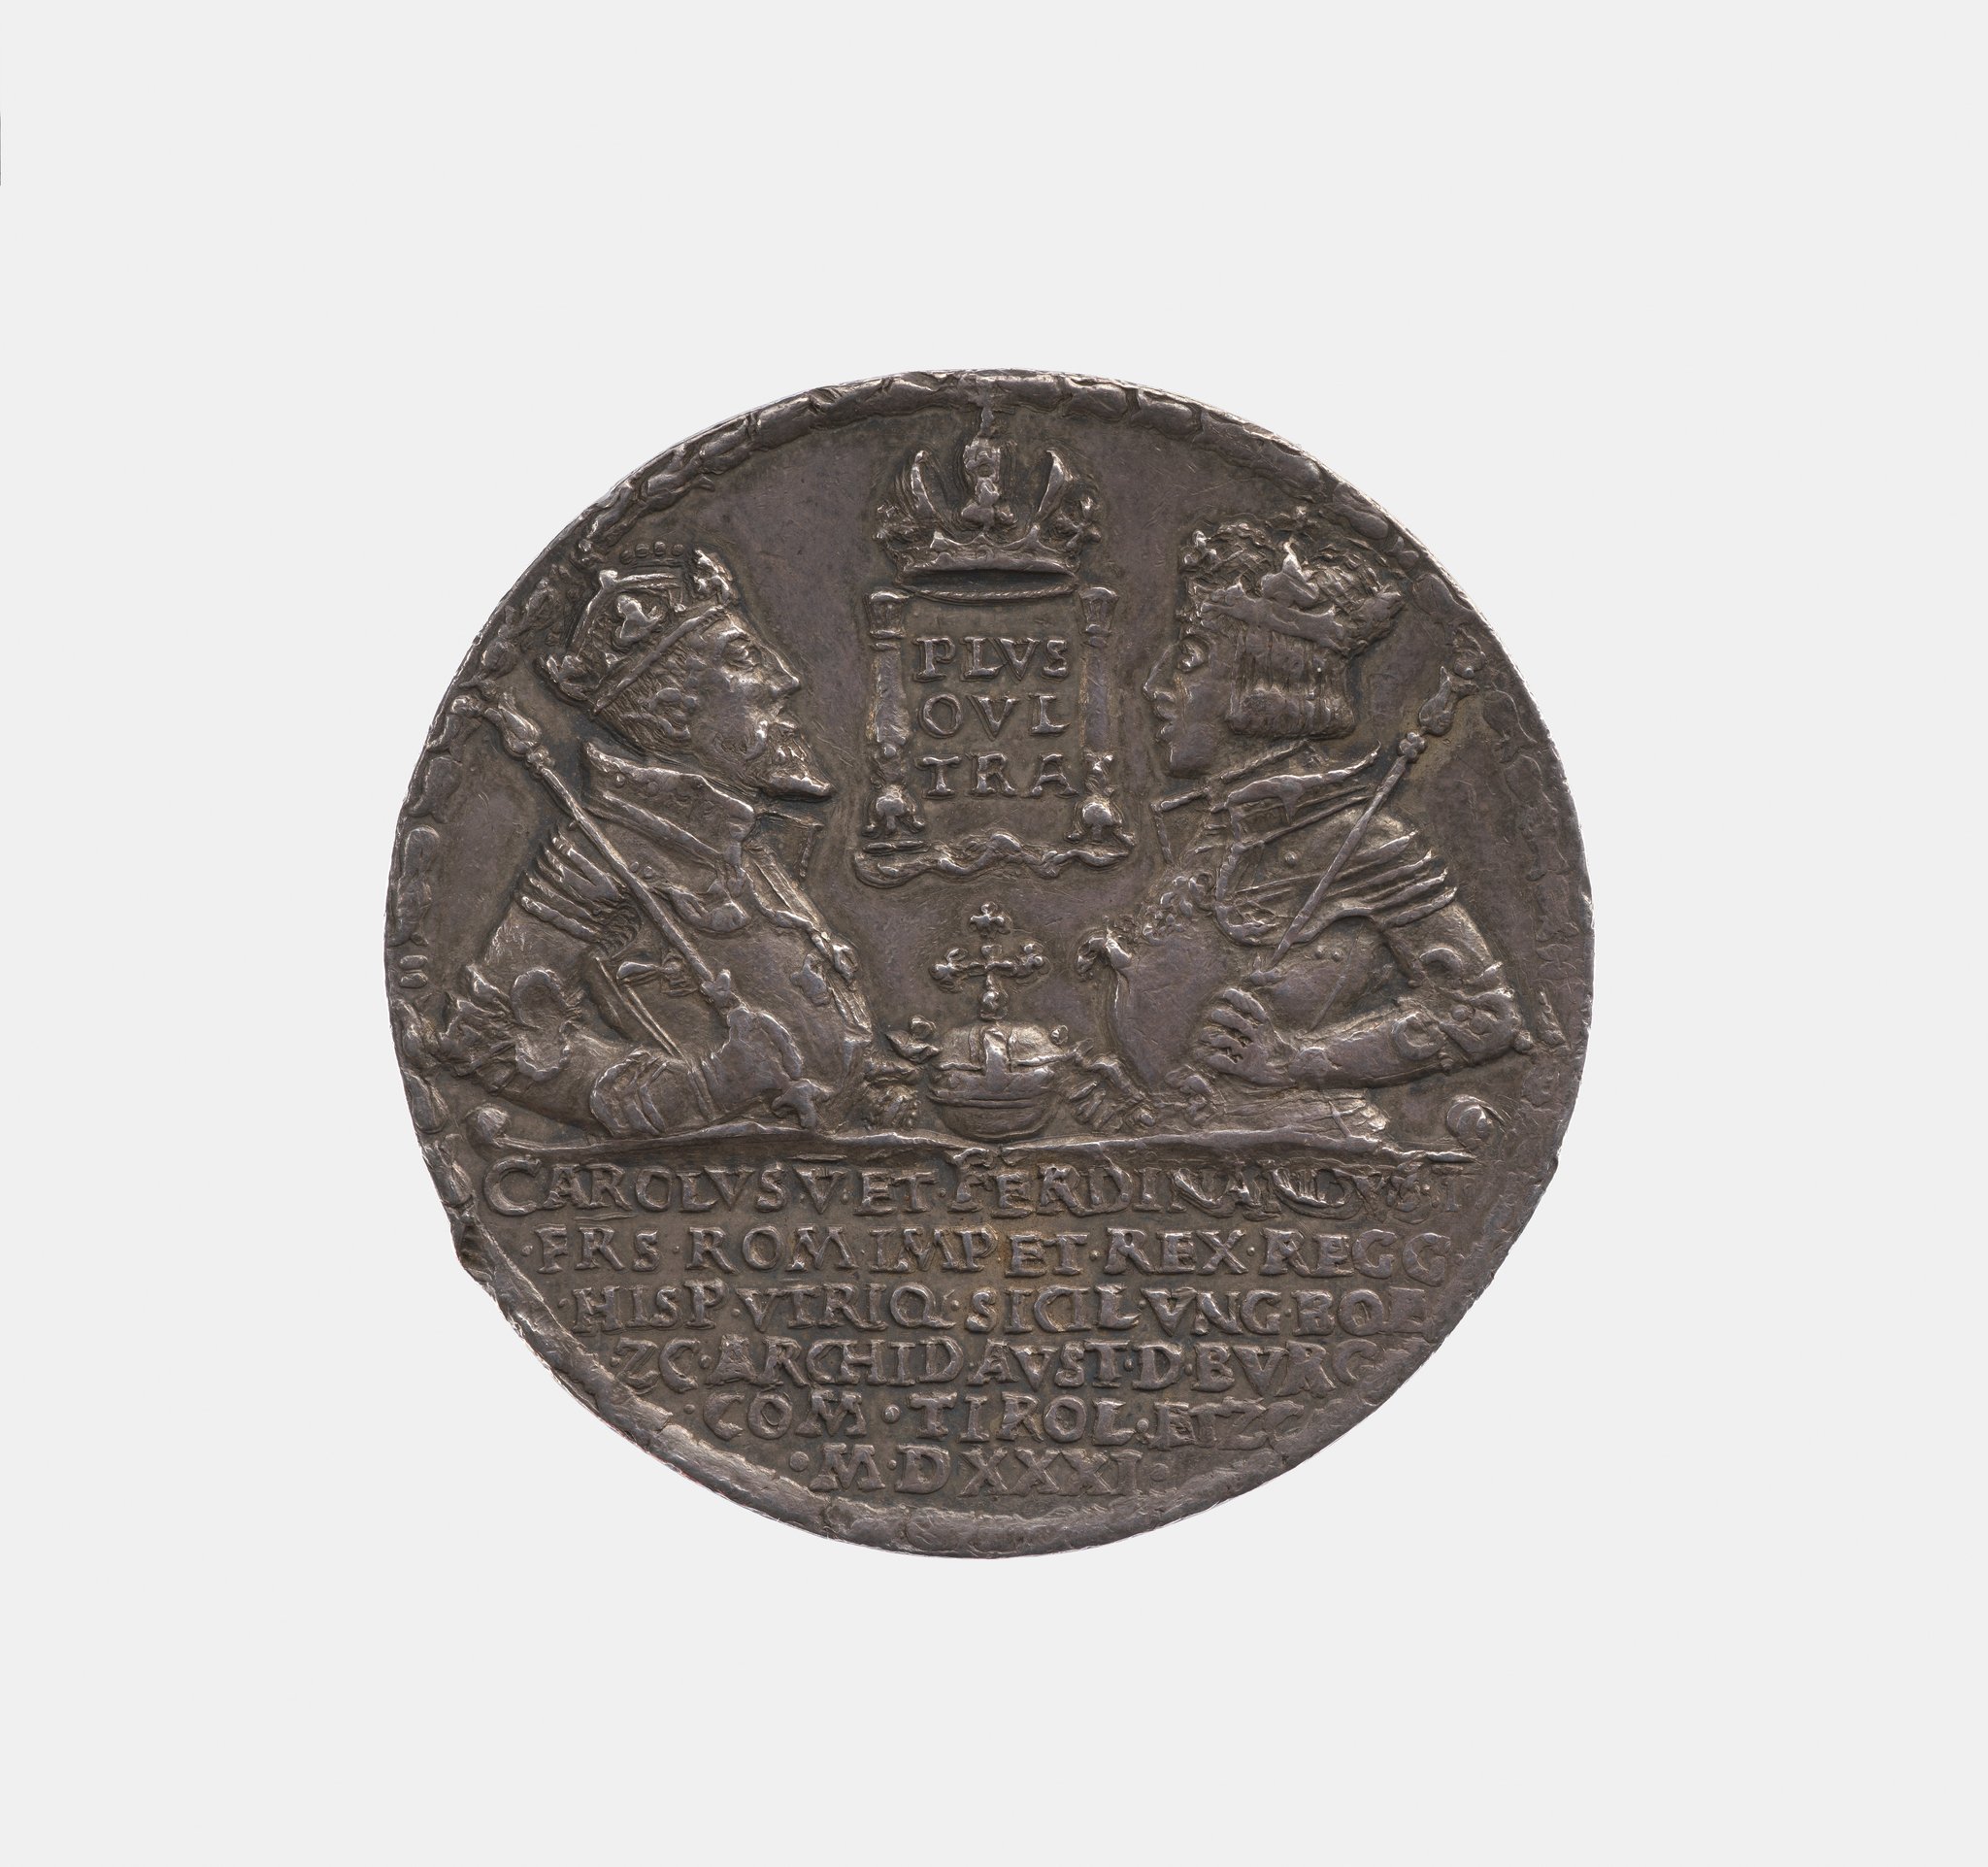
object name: medal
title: Charles V and Fedinand I (schautaler)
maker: christoph loch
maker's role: artist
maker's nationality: german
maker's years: 1530-1630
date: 1531-1550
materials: silver